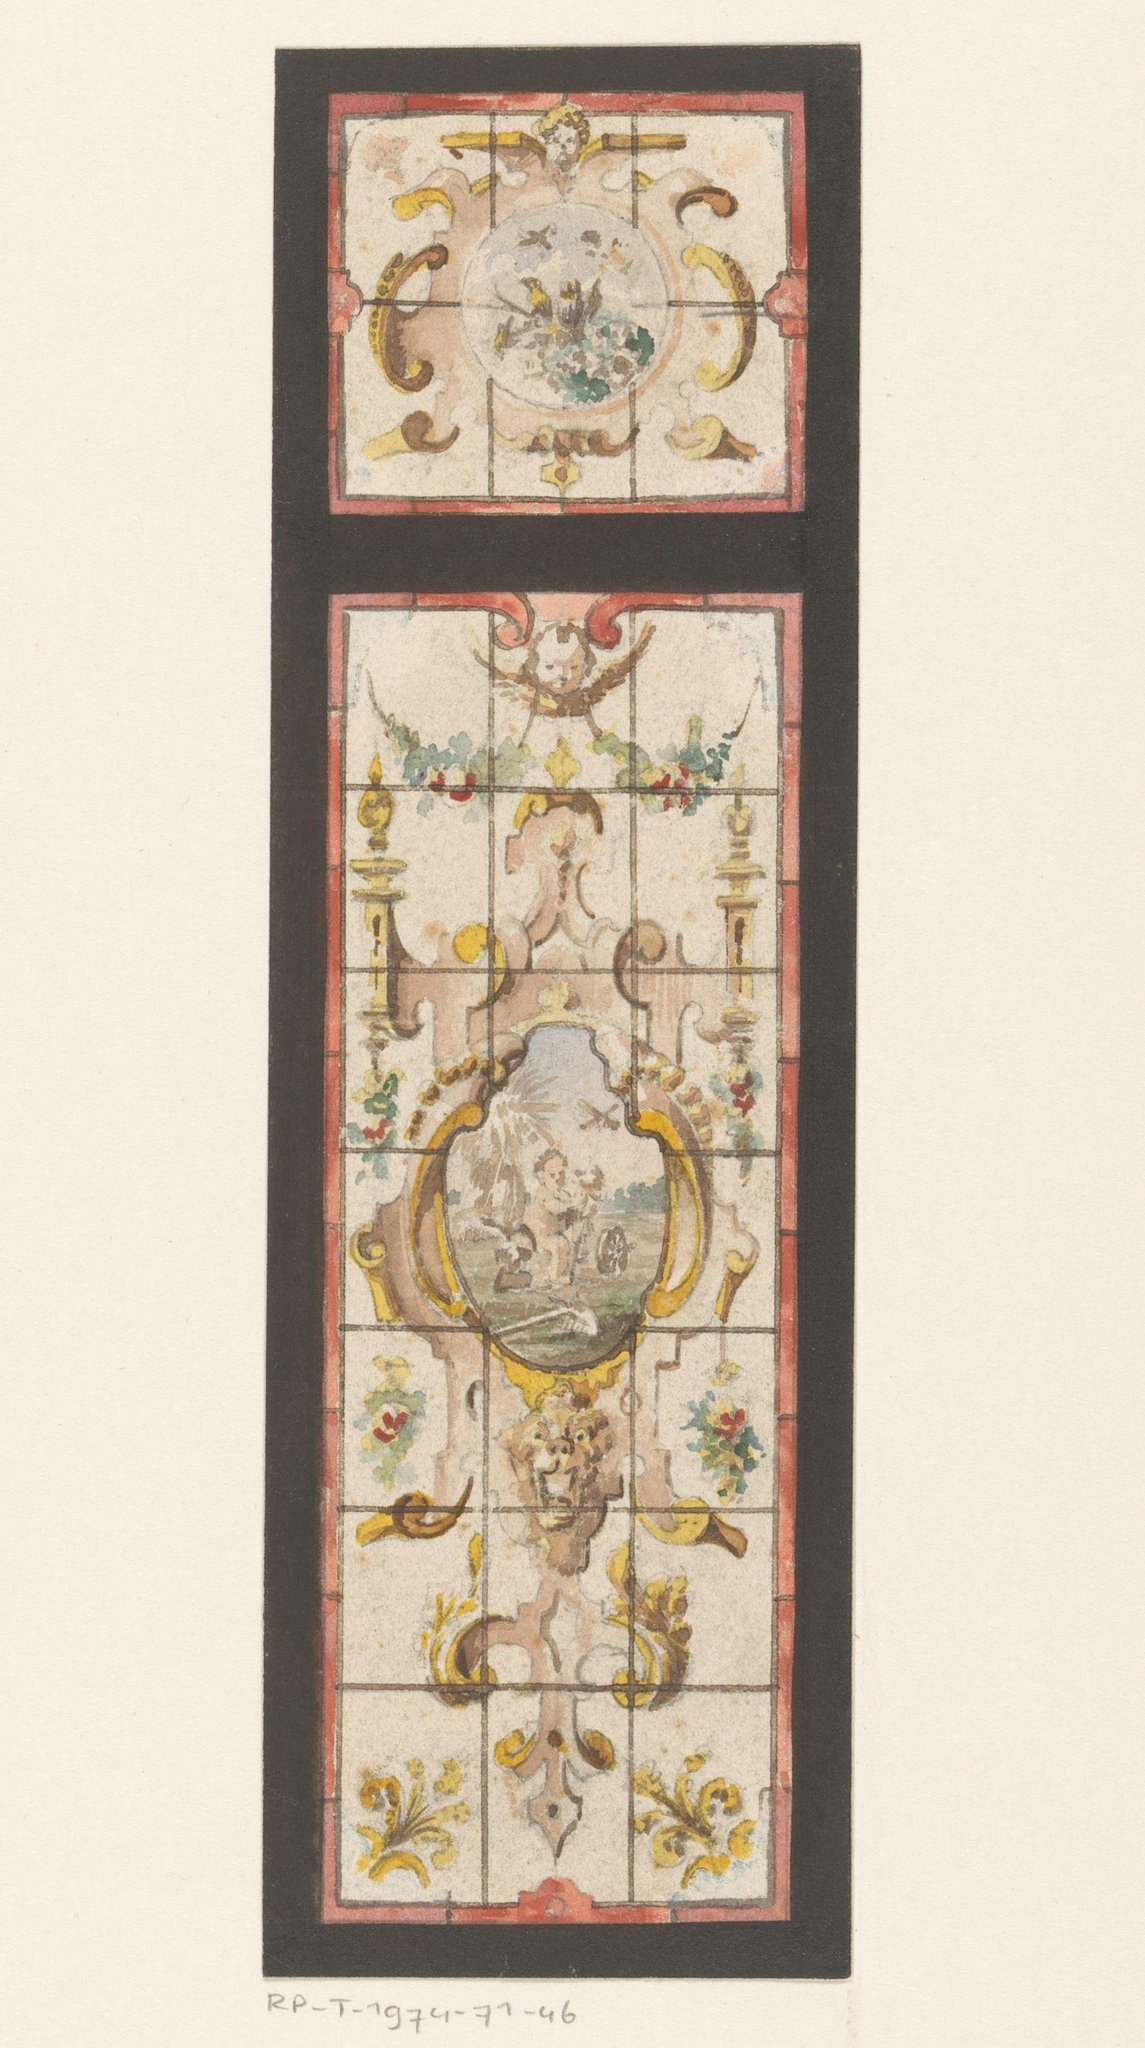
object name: drawing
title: Ontwerp voor een glas in loodraam met putto in een cartouche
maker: Anonymous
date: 1907-1930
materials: ink, paper, watercolor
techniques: brush, pen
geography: amsterdam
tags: ornament ~ cartouche, cupids: 'amores', 'amoretti', 'putti'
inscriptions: collector's mark: ‘R:MVS’, company name: ‘Firma E. LÖHRER./ Hofleverancier./ Stationsplein 17, UTRECHT./ Opgericht 1882.’